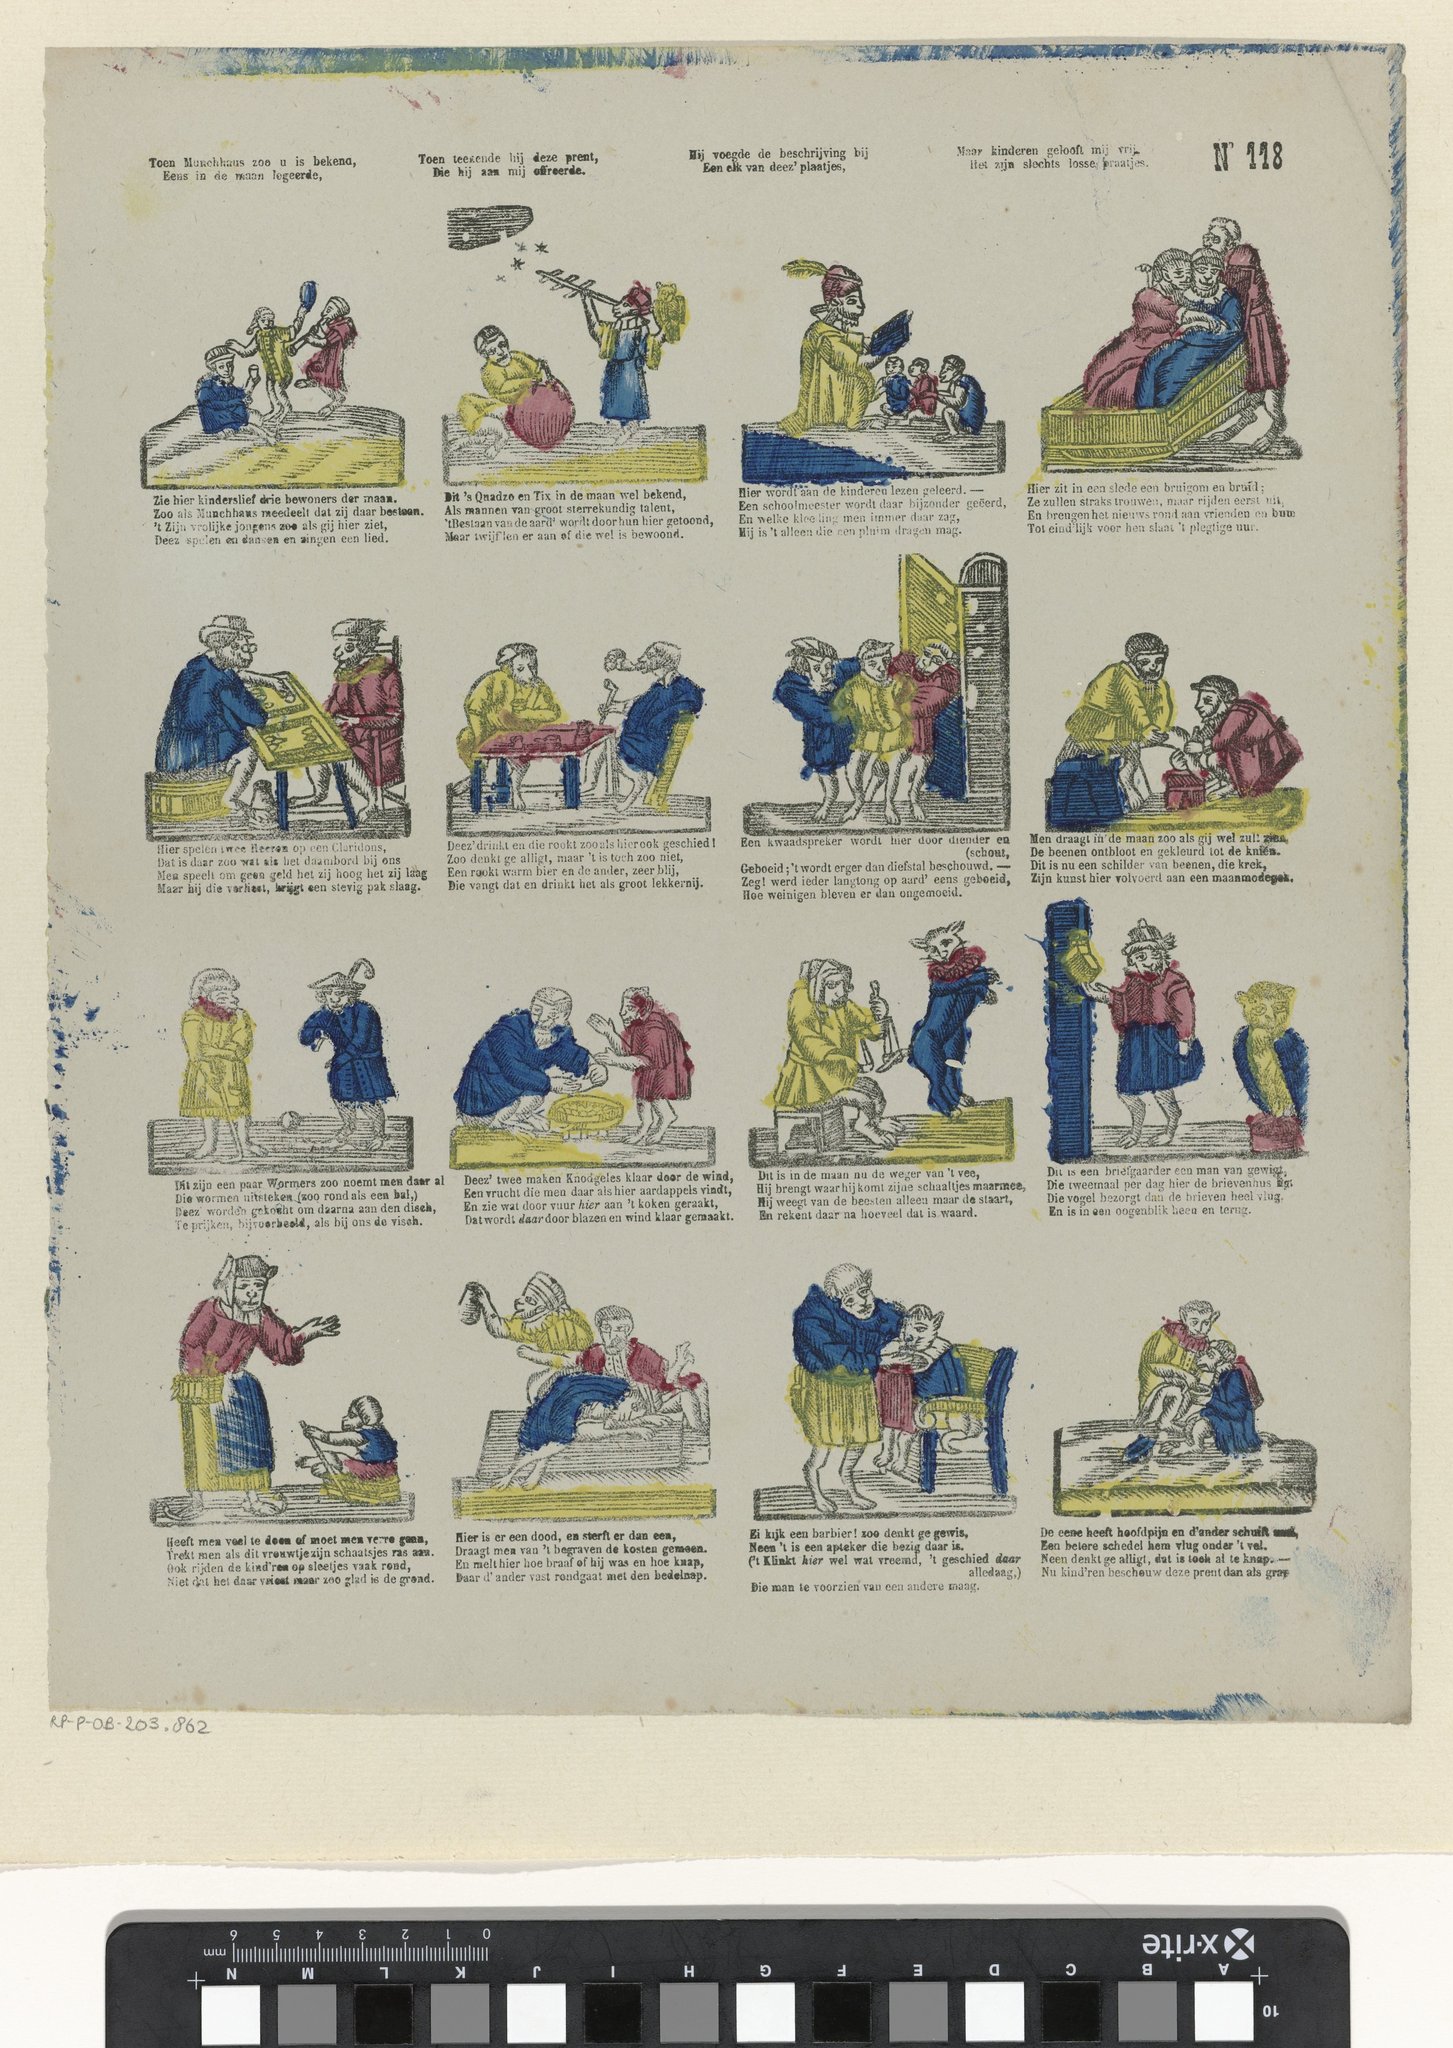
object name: popular print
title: Toen Munchhaus zoo u is bekend, / Eens in de maan logeerde [(...)]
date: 1827-1894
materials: paper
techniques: colour, letterpress printing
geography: schaarbeek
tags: monkeys, apes, animals acting as human beings, moon as celestial body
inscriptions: collector's mark: Lugt 2760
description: Blad met 16 voorstellingen van apen op de maan, die zich als mensen gedragen. Onder elke afbeelding een vierregelig vers. Genummerd rechtsboven: No 118.